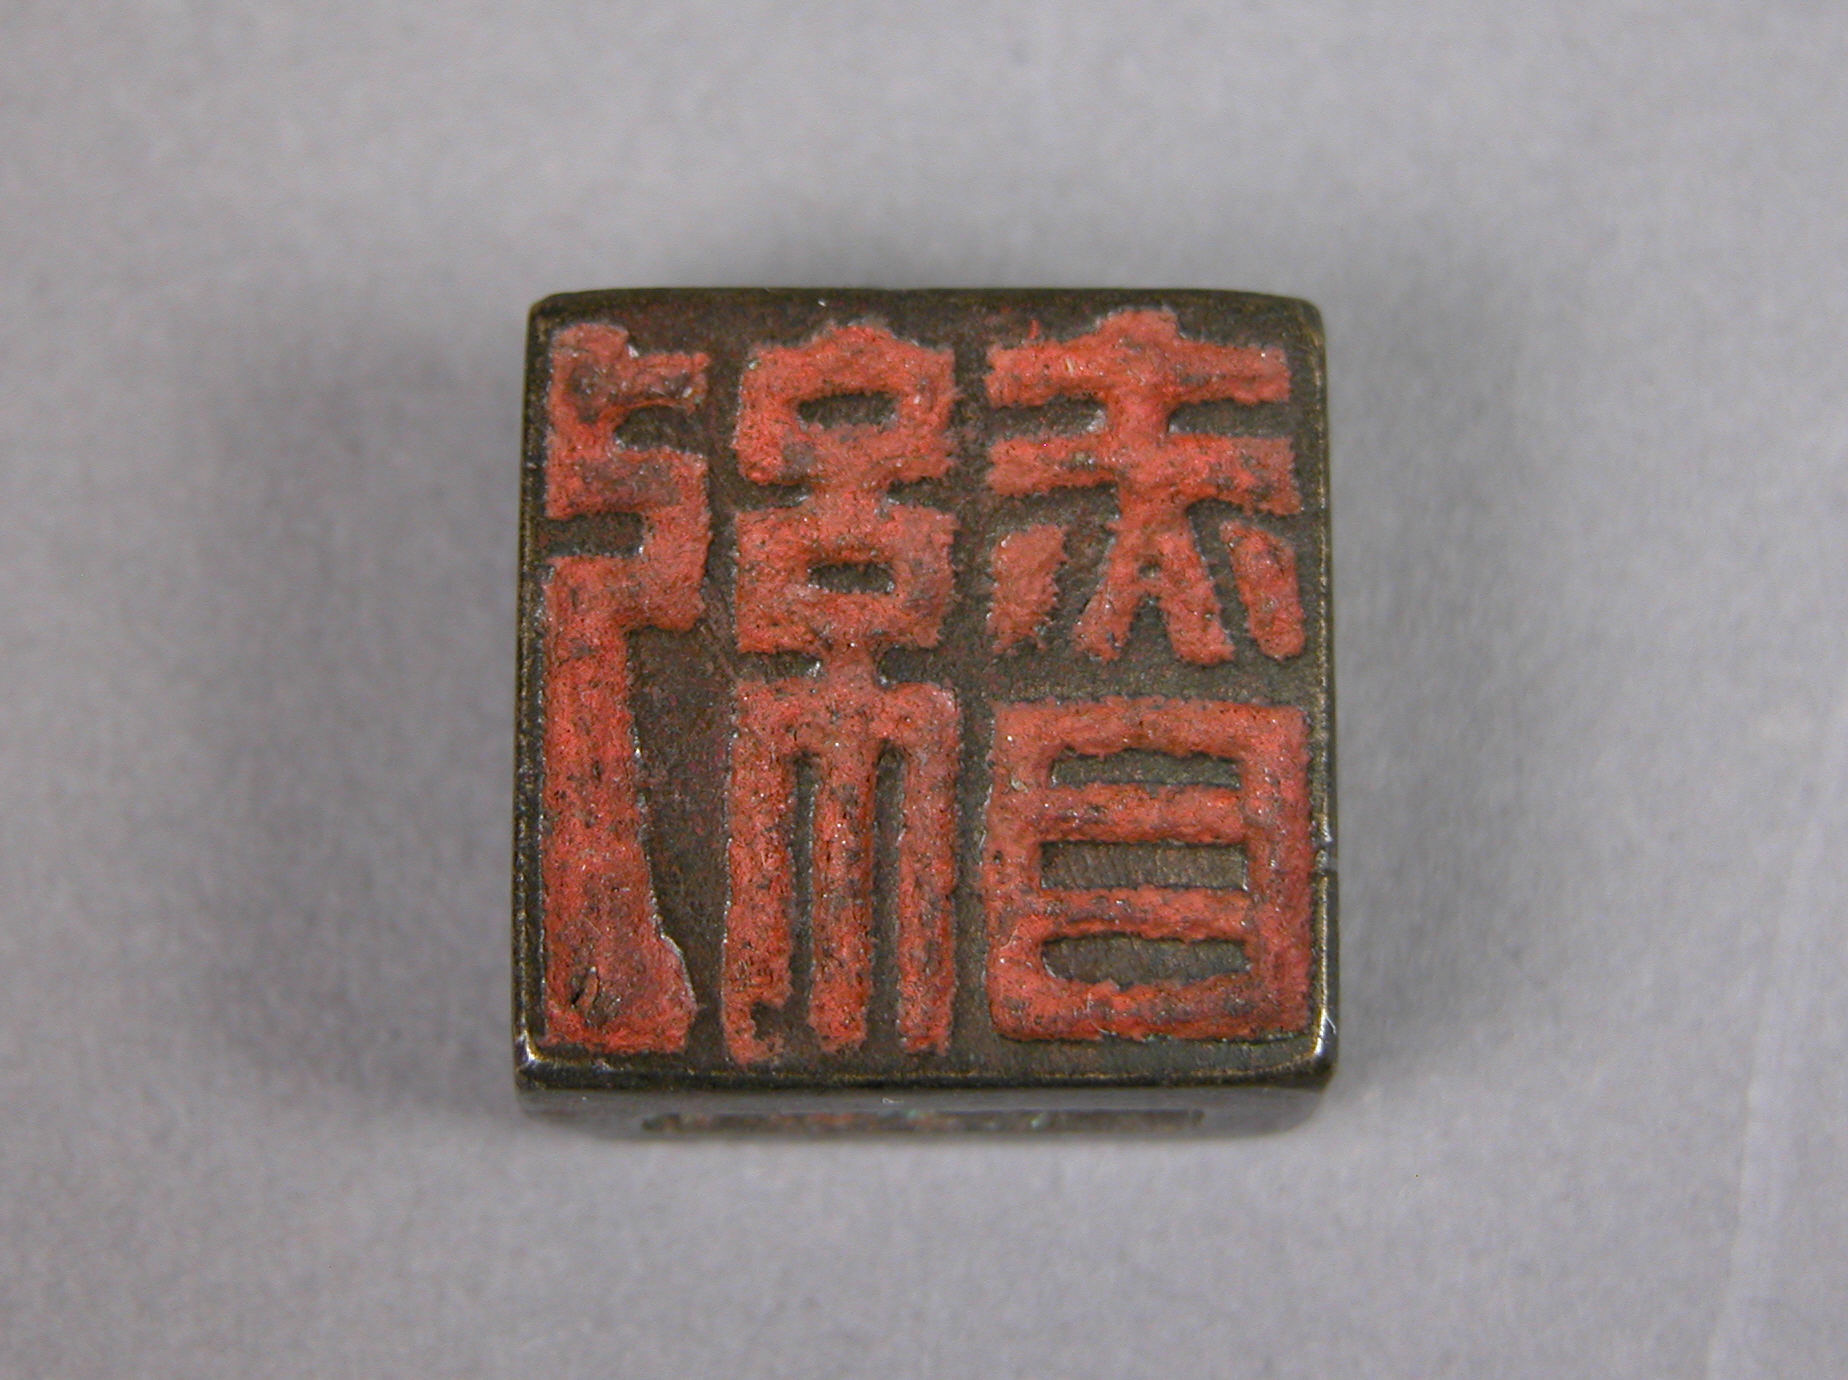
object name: seal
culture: chinese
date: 1368-1644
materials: bronze